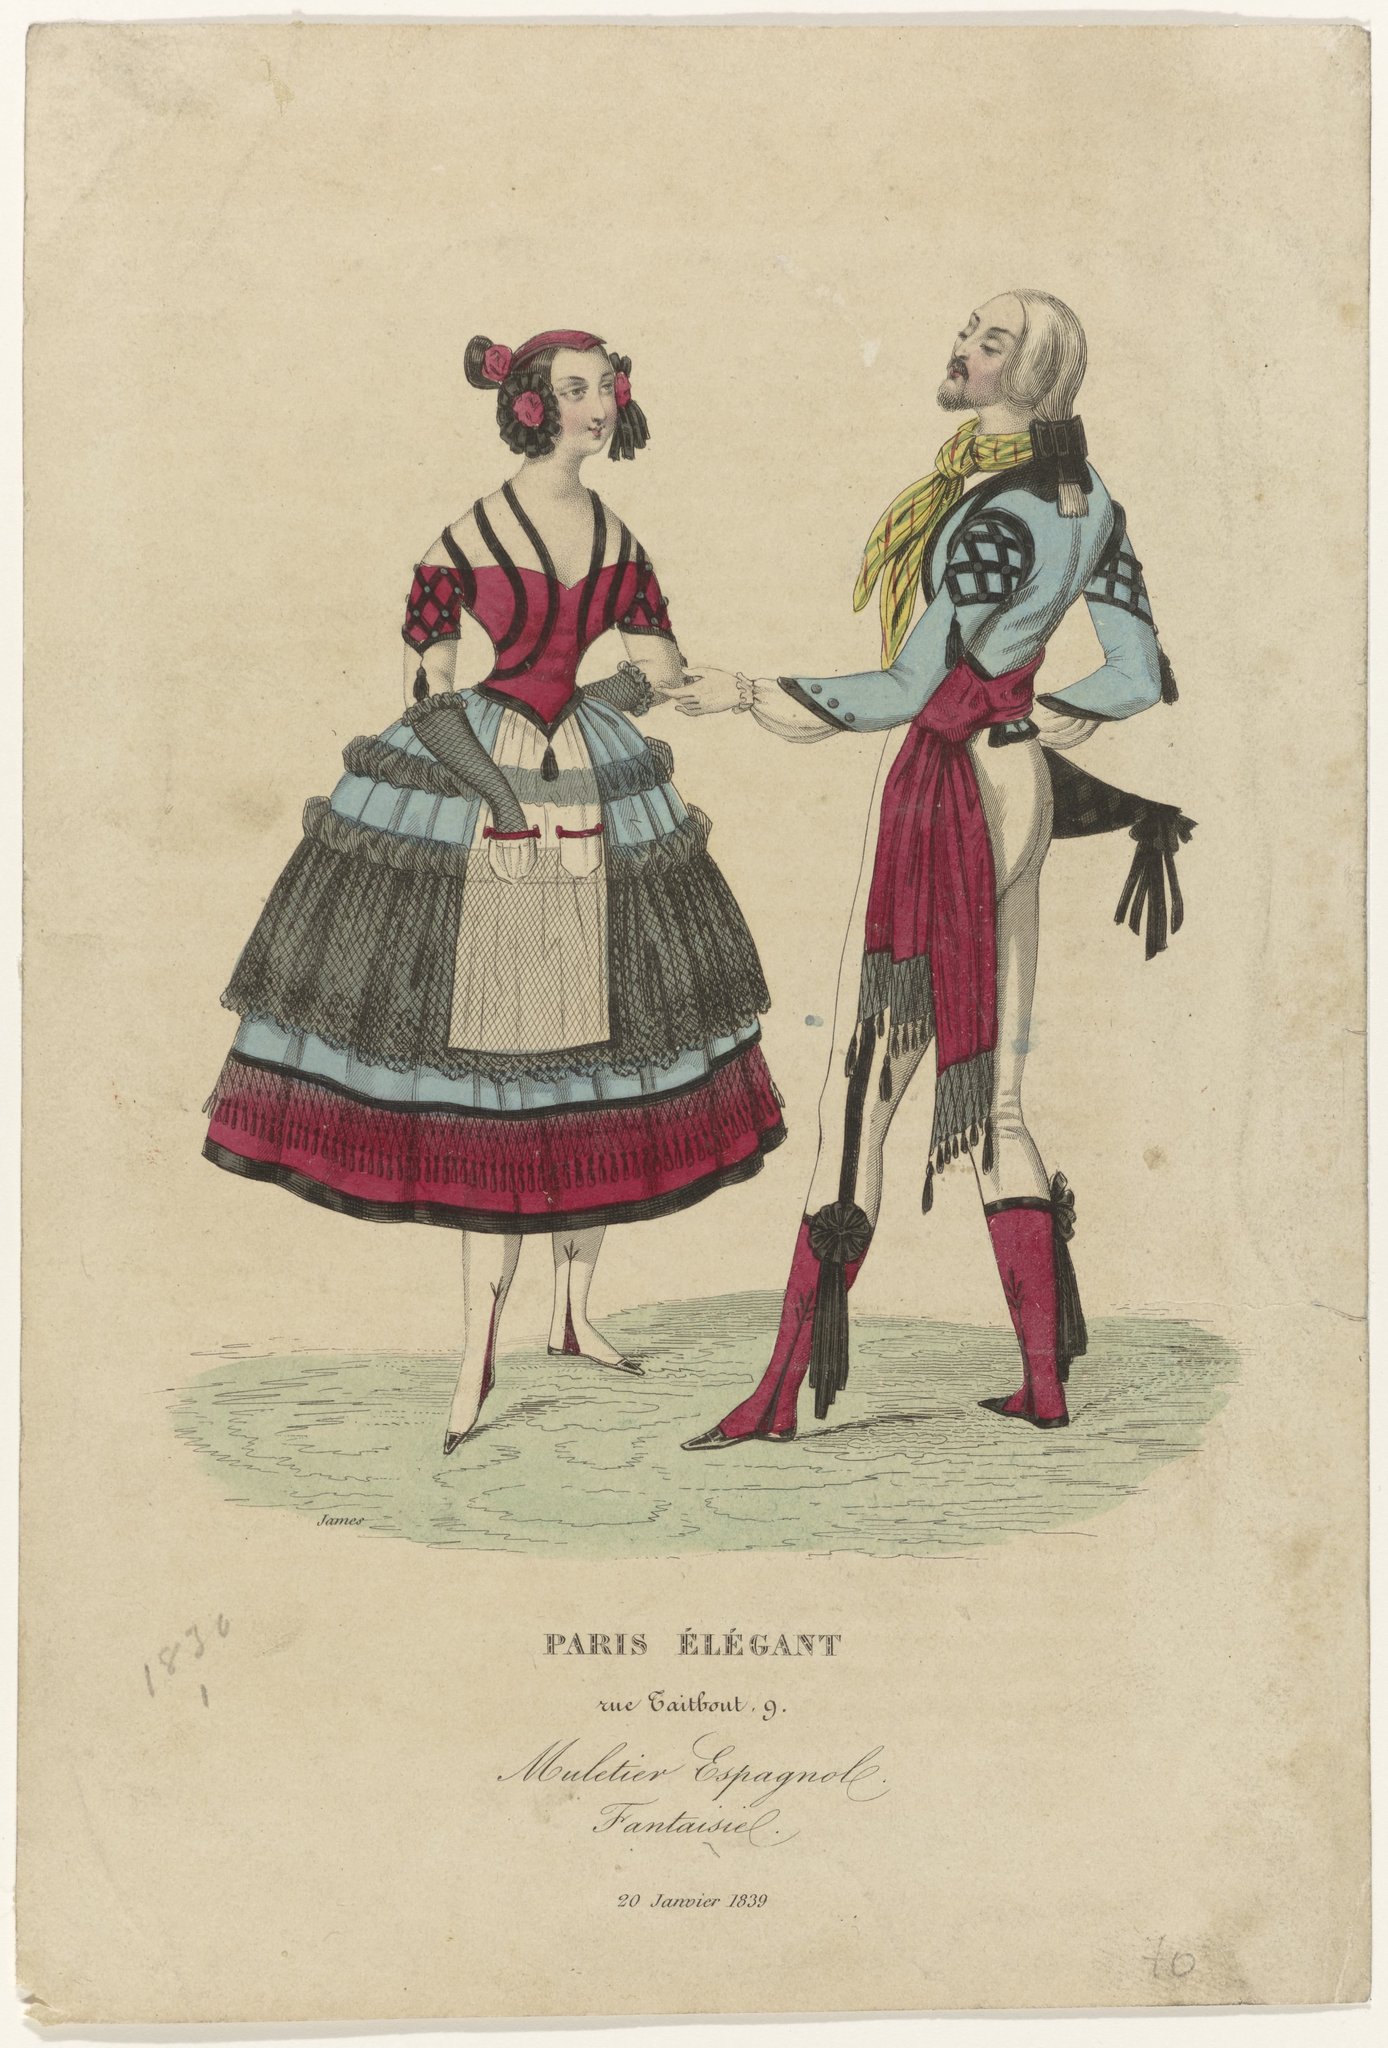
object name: fashion print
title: Paris Elégant, 20 janvier 1839 : Muletier Espagnol Fantaisie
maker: Anonymous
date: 1839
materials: paper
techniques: engraving, hand coloring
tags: party clothes, festive attire (+ women's clothes), party clothes, festive attire (+ men's clothes), fashion plates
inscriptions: caption: ‘Muletier Espagnol Fantaisie’, title: ‘Paris Élégant’, address: ‘rue Taitbout, 9.’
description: Een man en vrouw, verkleed in gefantaseerd Spaanse kostuums. Prent uit het modetijdschrift Paris Élégant (1836-1881).